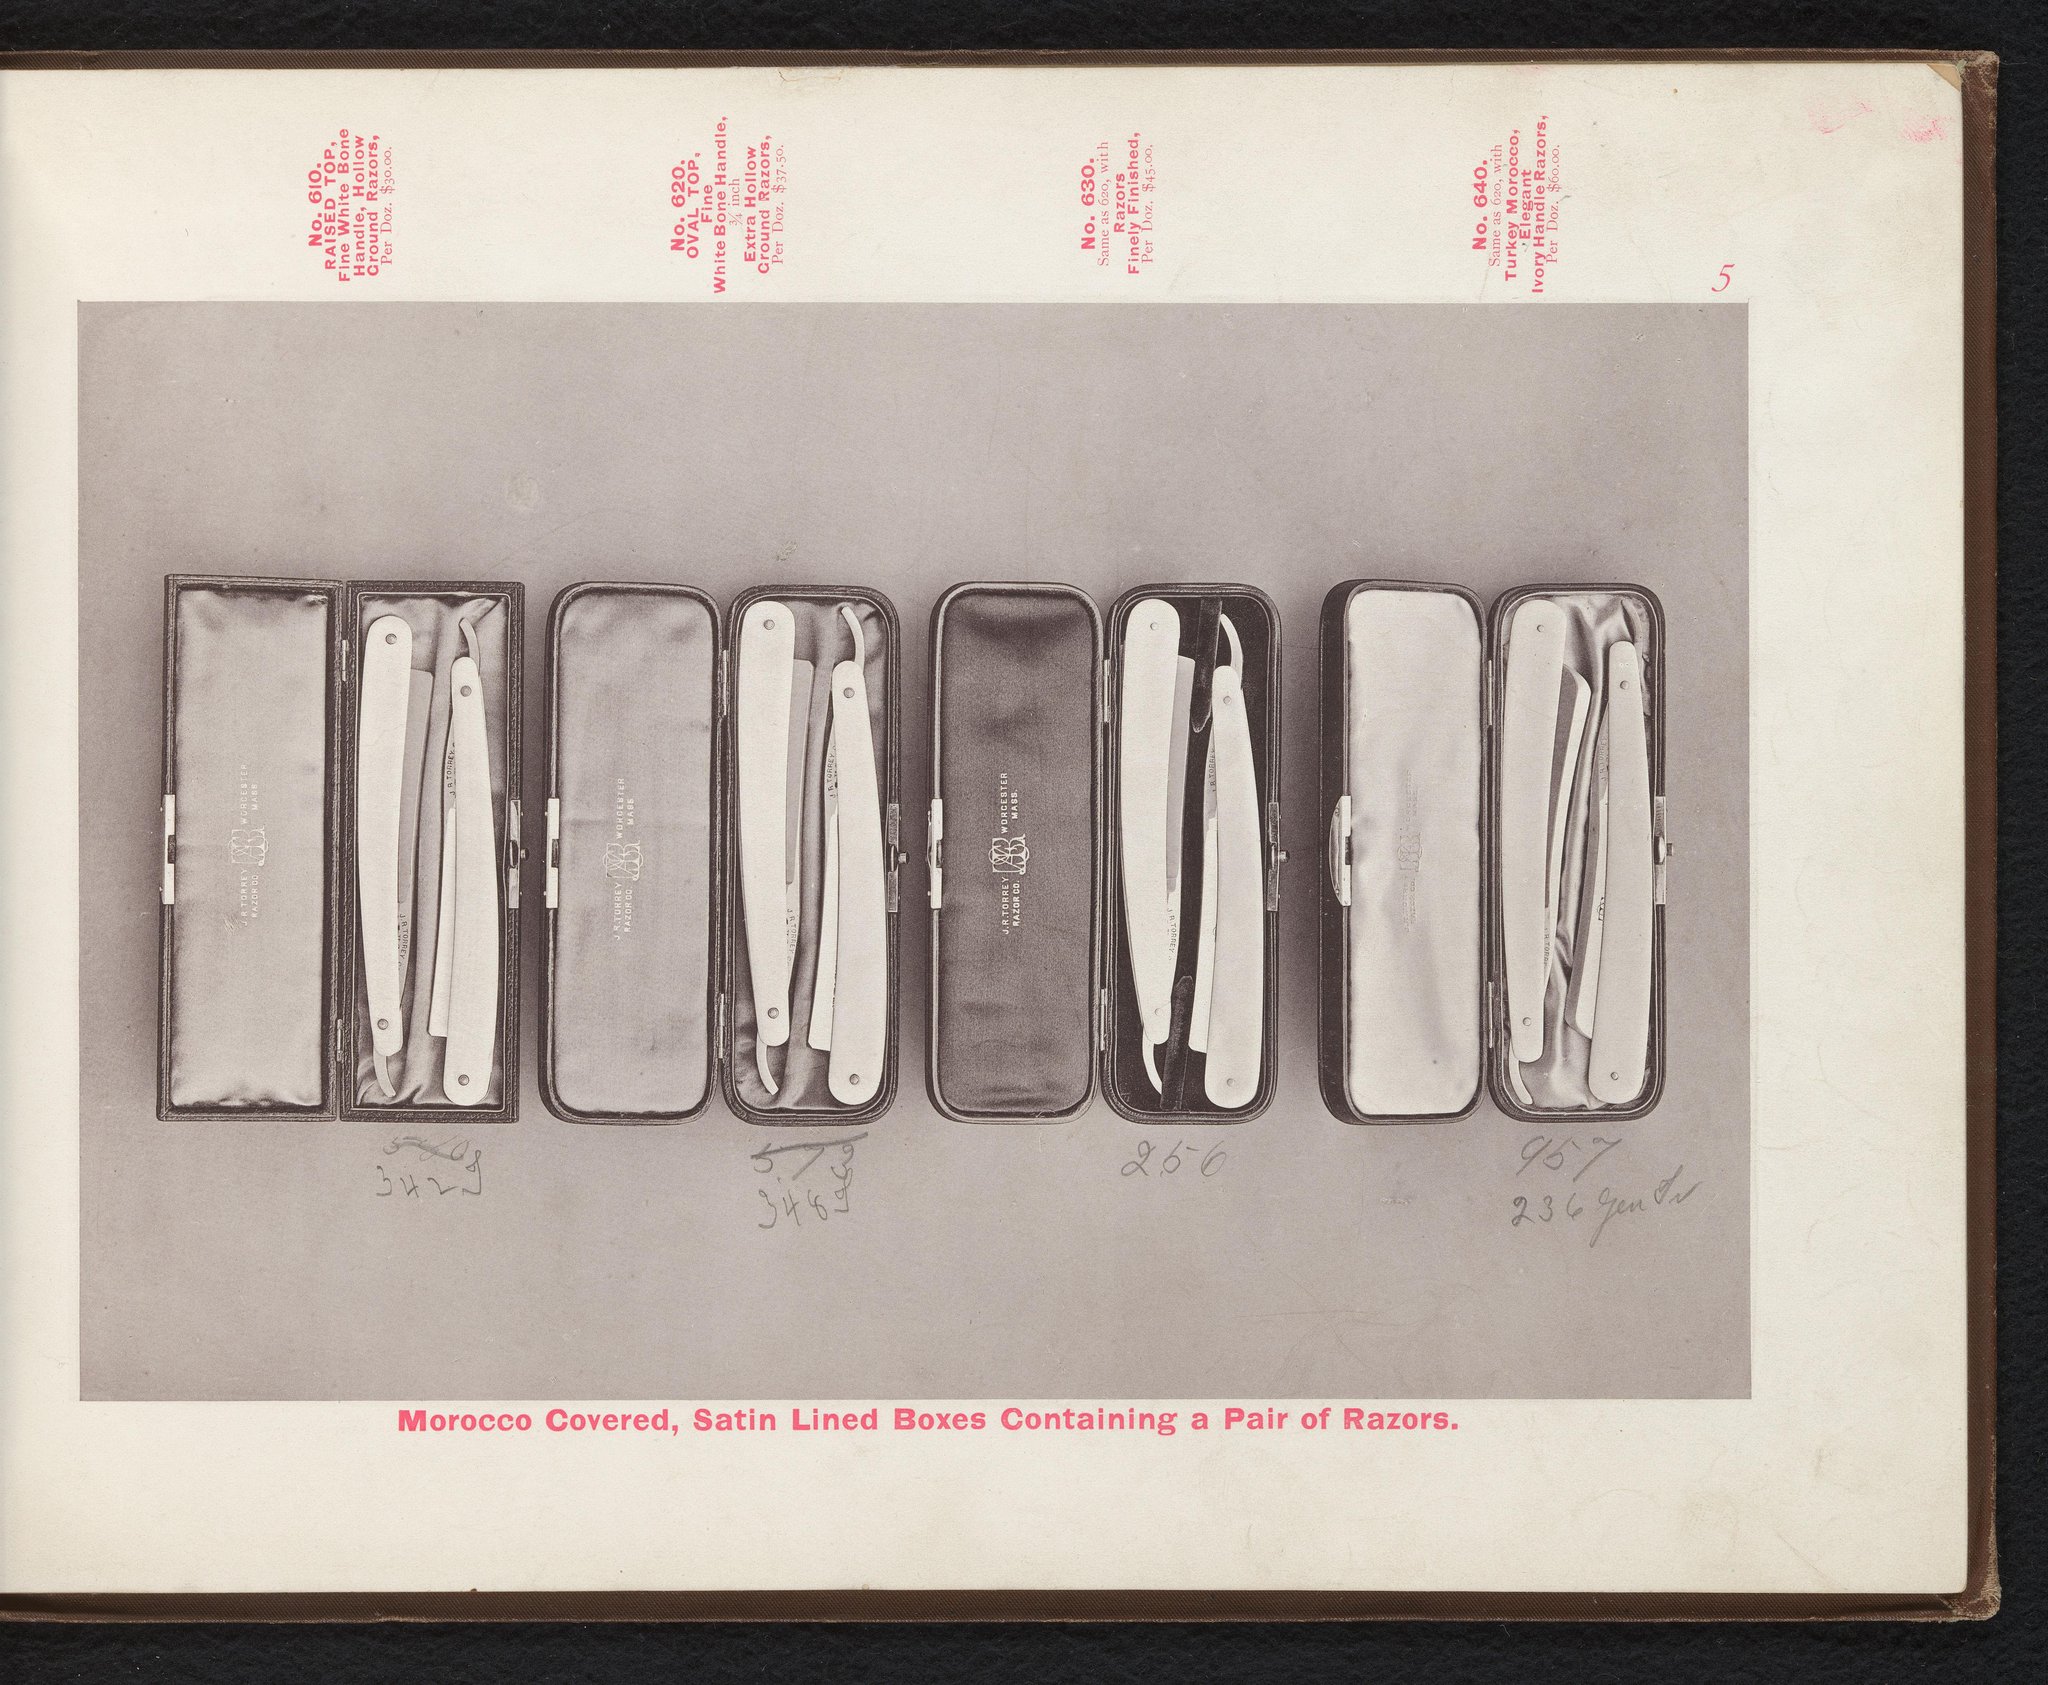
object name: page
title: Morocco covered, satin lined boxes containing a pair of razors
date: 1876-1881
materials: paper, pencil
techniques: photograph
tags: razor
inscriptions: number: ‘3429/ 3489/ 256/ 967/ 236 (...)’